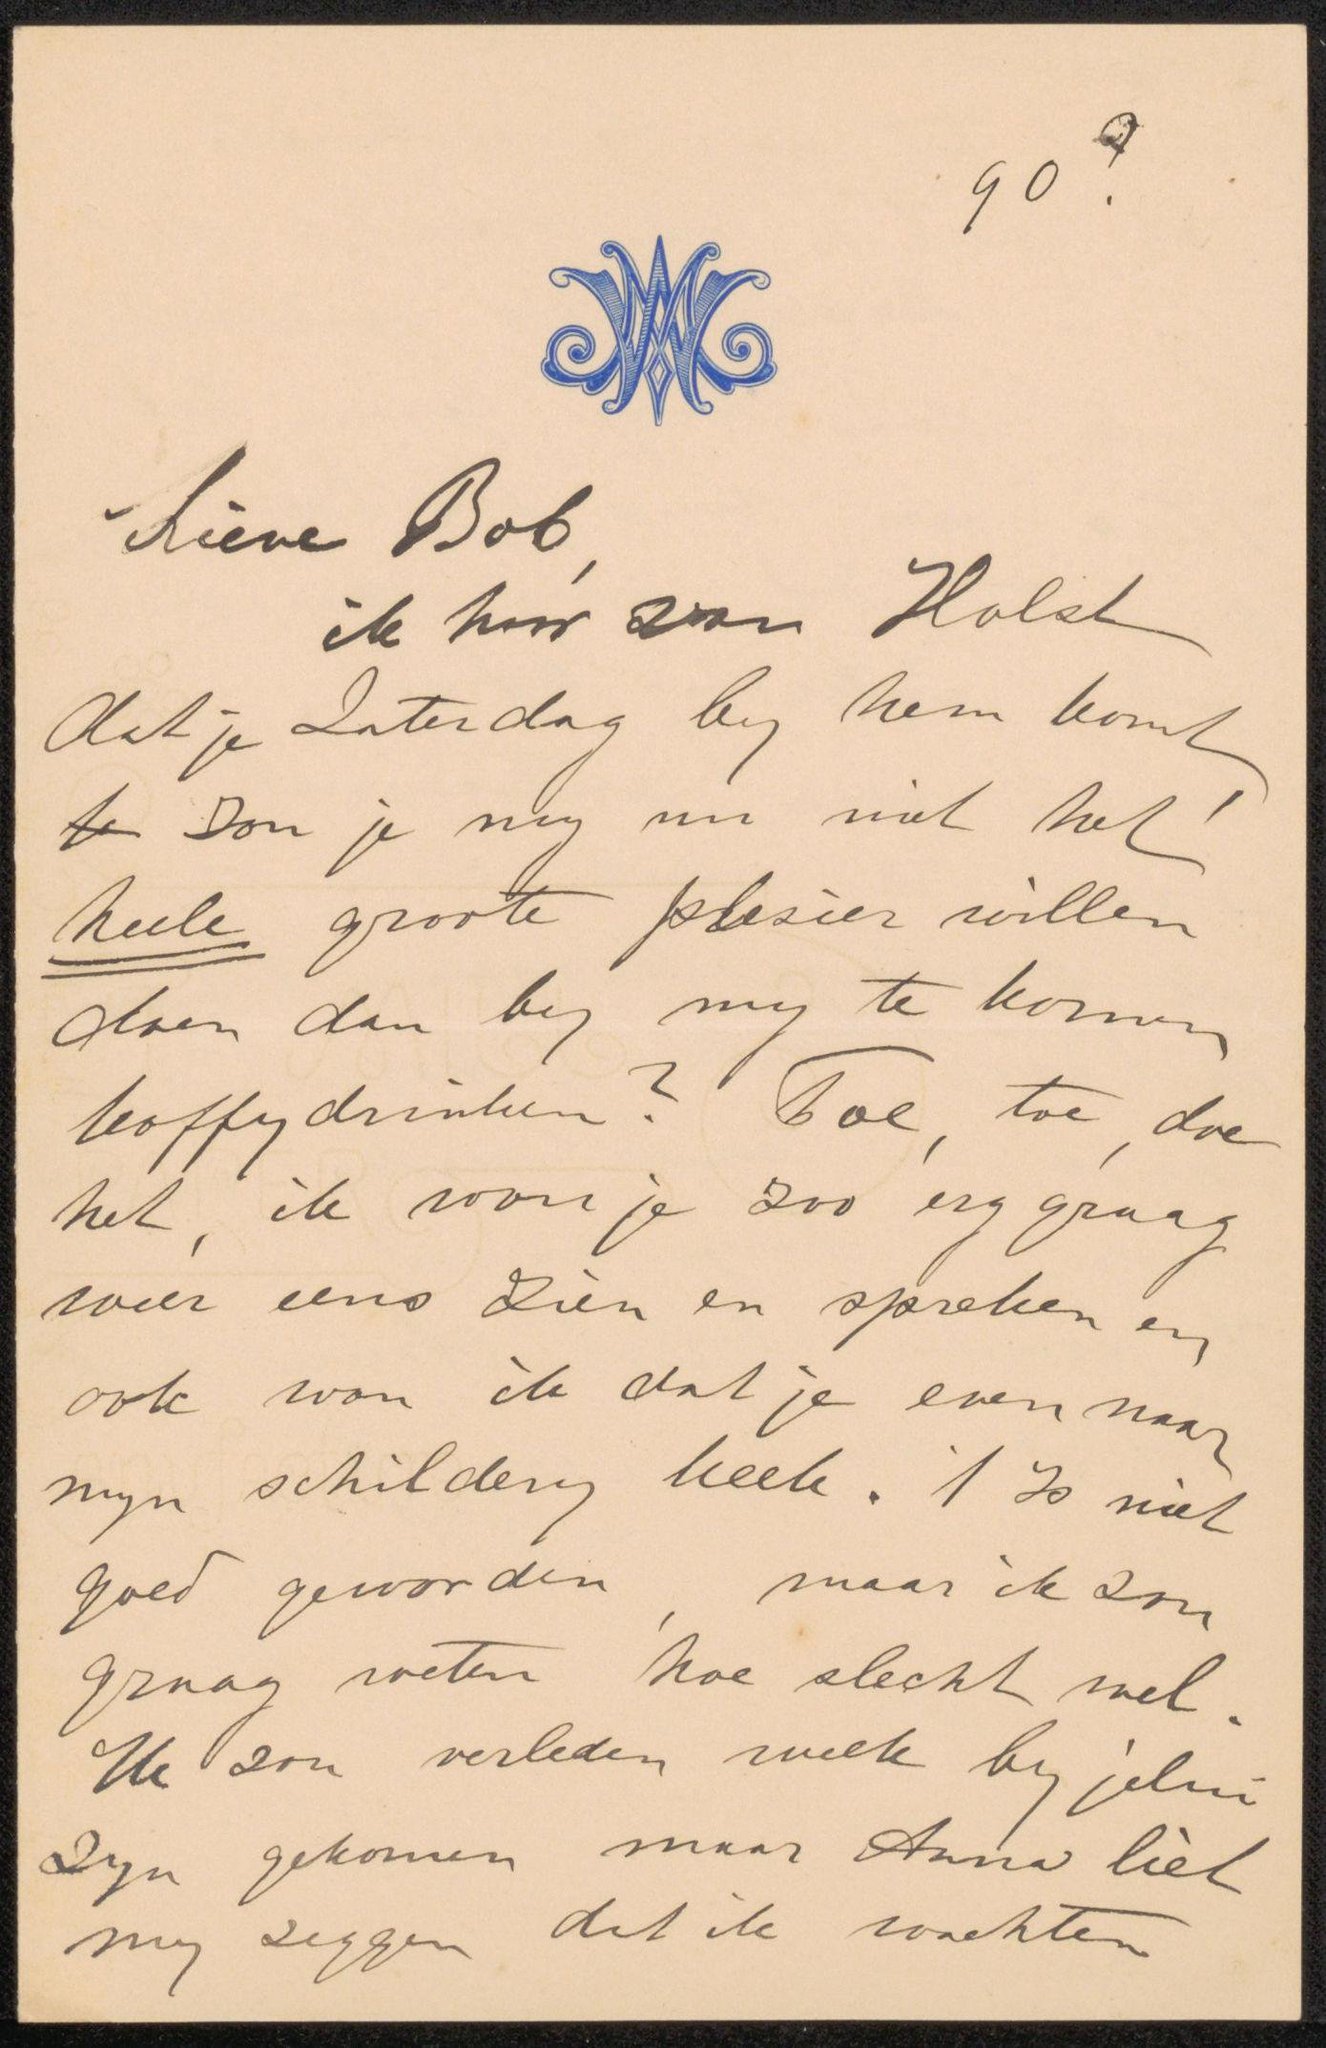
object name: letter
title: Brief aan Jan Veth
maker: wally moes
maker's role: draughtsman, print maker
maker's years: 1856-1918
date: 1866-1918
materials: ink, paper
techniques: pen, writing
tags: dordrecht, painter, designer, jan veth, richard nicolaüs roland holst, painting (including book-illumination, miniature-painting)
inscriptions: collector's mark: ‘RPK’, watermark, monogram: ‘WM’